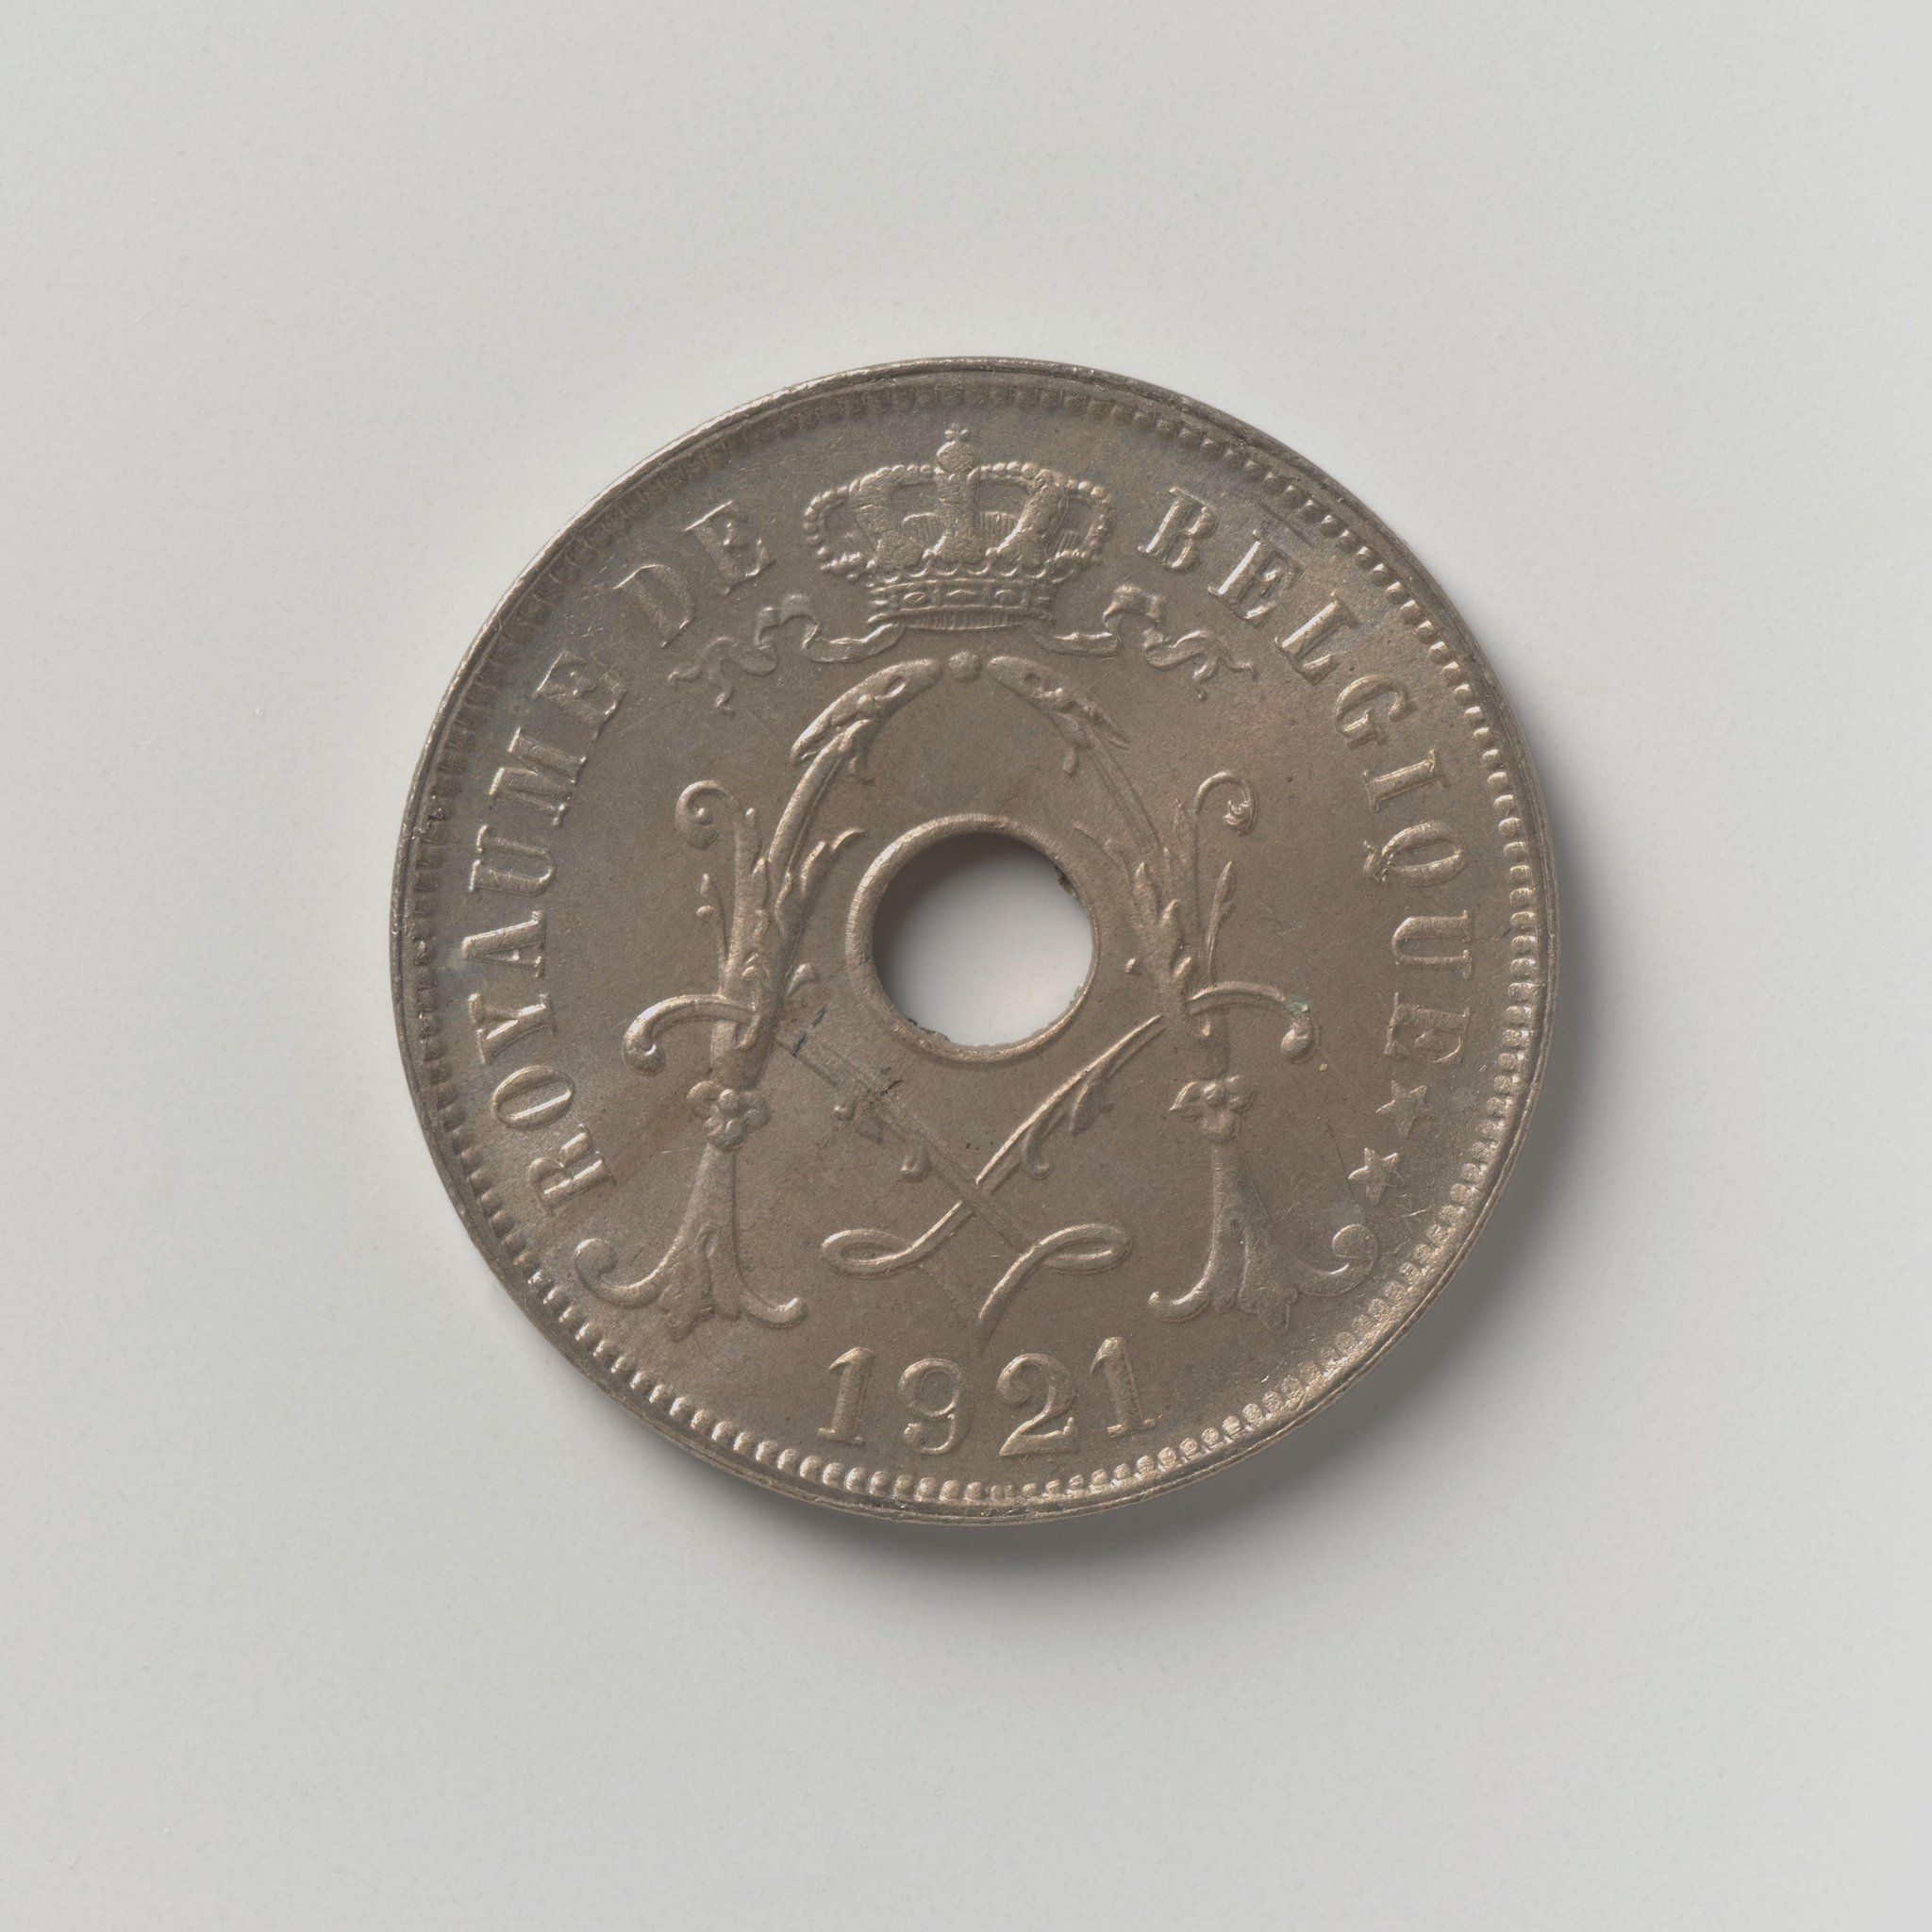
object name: vijfentwintig centime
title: België, Albert I, 25 centimes, 1921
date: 1921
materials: nickel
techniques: striking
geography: brussels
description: Nikkelen munt. Voorzijde: gekroond monogram van letter A. Jaaartal onderaan. Keerzijde: rechts van gebogen lauwertak waarde-aanduiding 25 Ces. Centrale doorboring. Gladde rand.